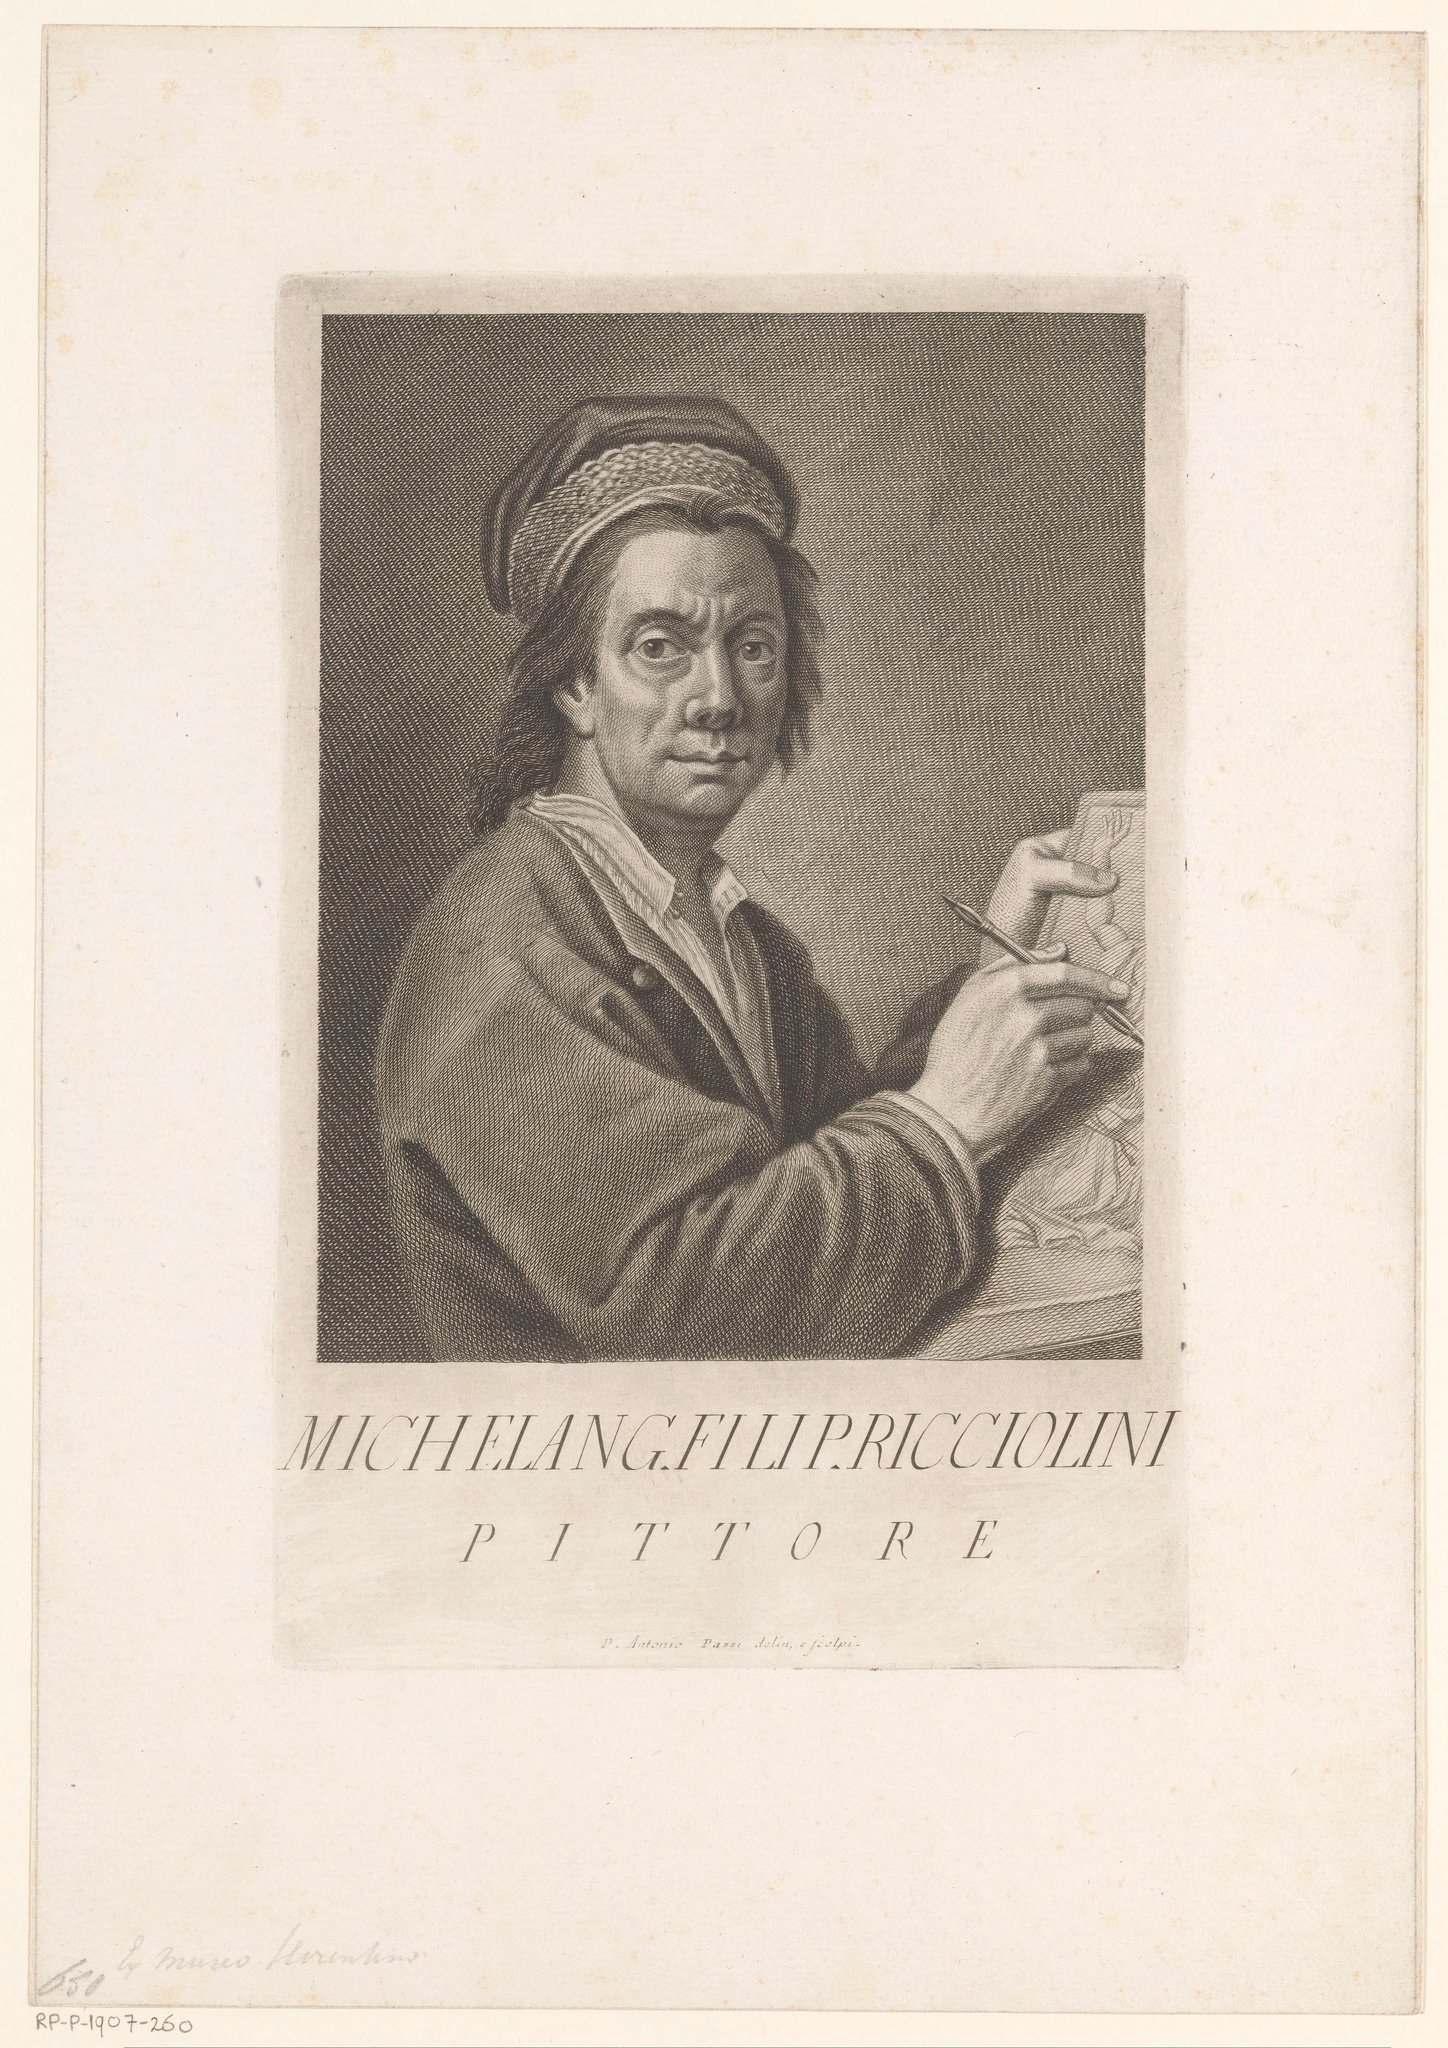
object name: book illustration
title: Portret van kunstenaar Michelangelo Ricciolini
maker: antonio pazzi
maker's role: painter, print maker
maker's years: 1706-1768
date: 1752-1762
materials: paper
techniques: engraving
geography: italy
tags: rome, painter, michelangelo ricciolini, drawing-instruments, historical persons, portrait, self-portrait of draughtsman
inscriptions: collector's mark: Lugt 2228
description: Prent naar geschilderd zelfportret van Michelangelo Ricciolini in de Galleria degli Uffizi te Florence (inv.nr. 1760). Prent uit: Moücke, Francesco. Serie di ritratti degli eccellenti pittori dipinti di propria mano, che esistono nell'Imiperial Galleria di Firenze. Florence: 1752-1762, dl. II, dl. 2.